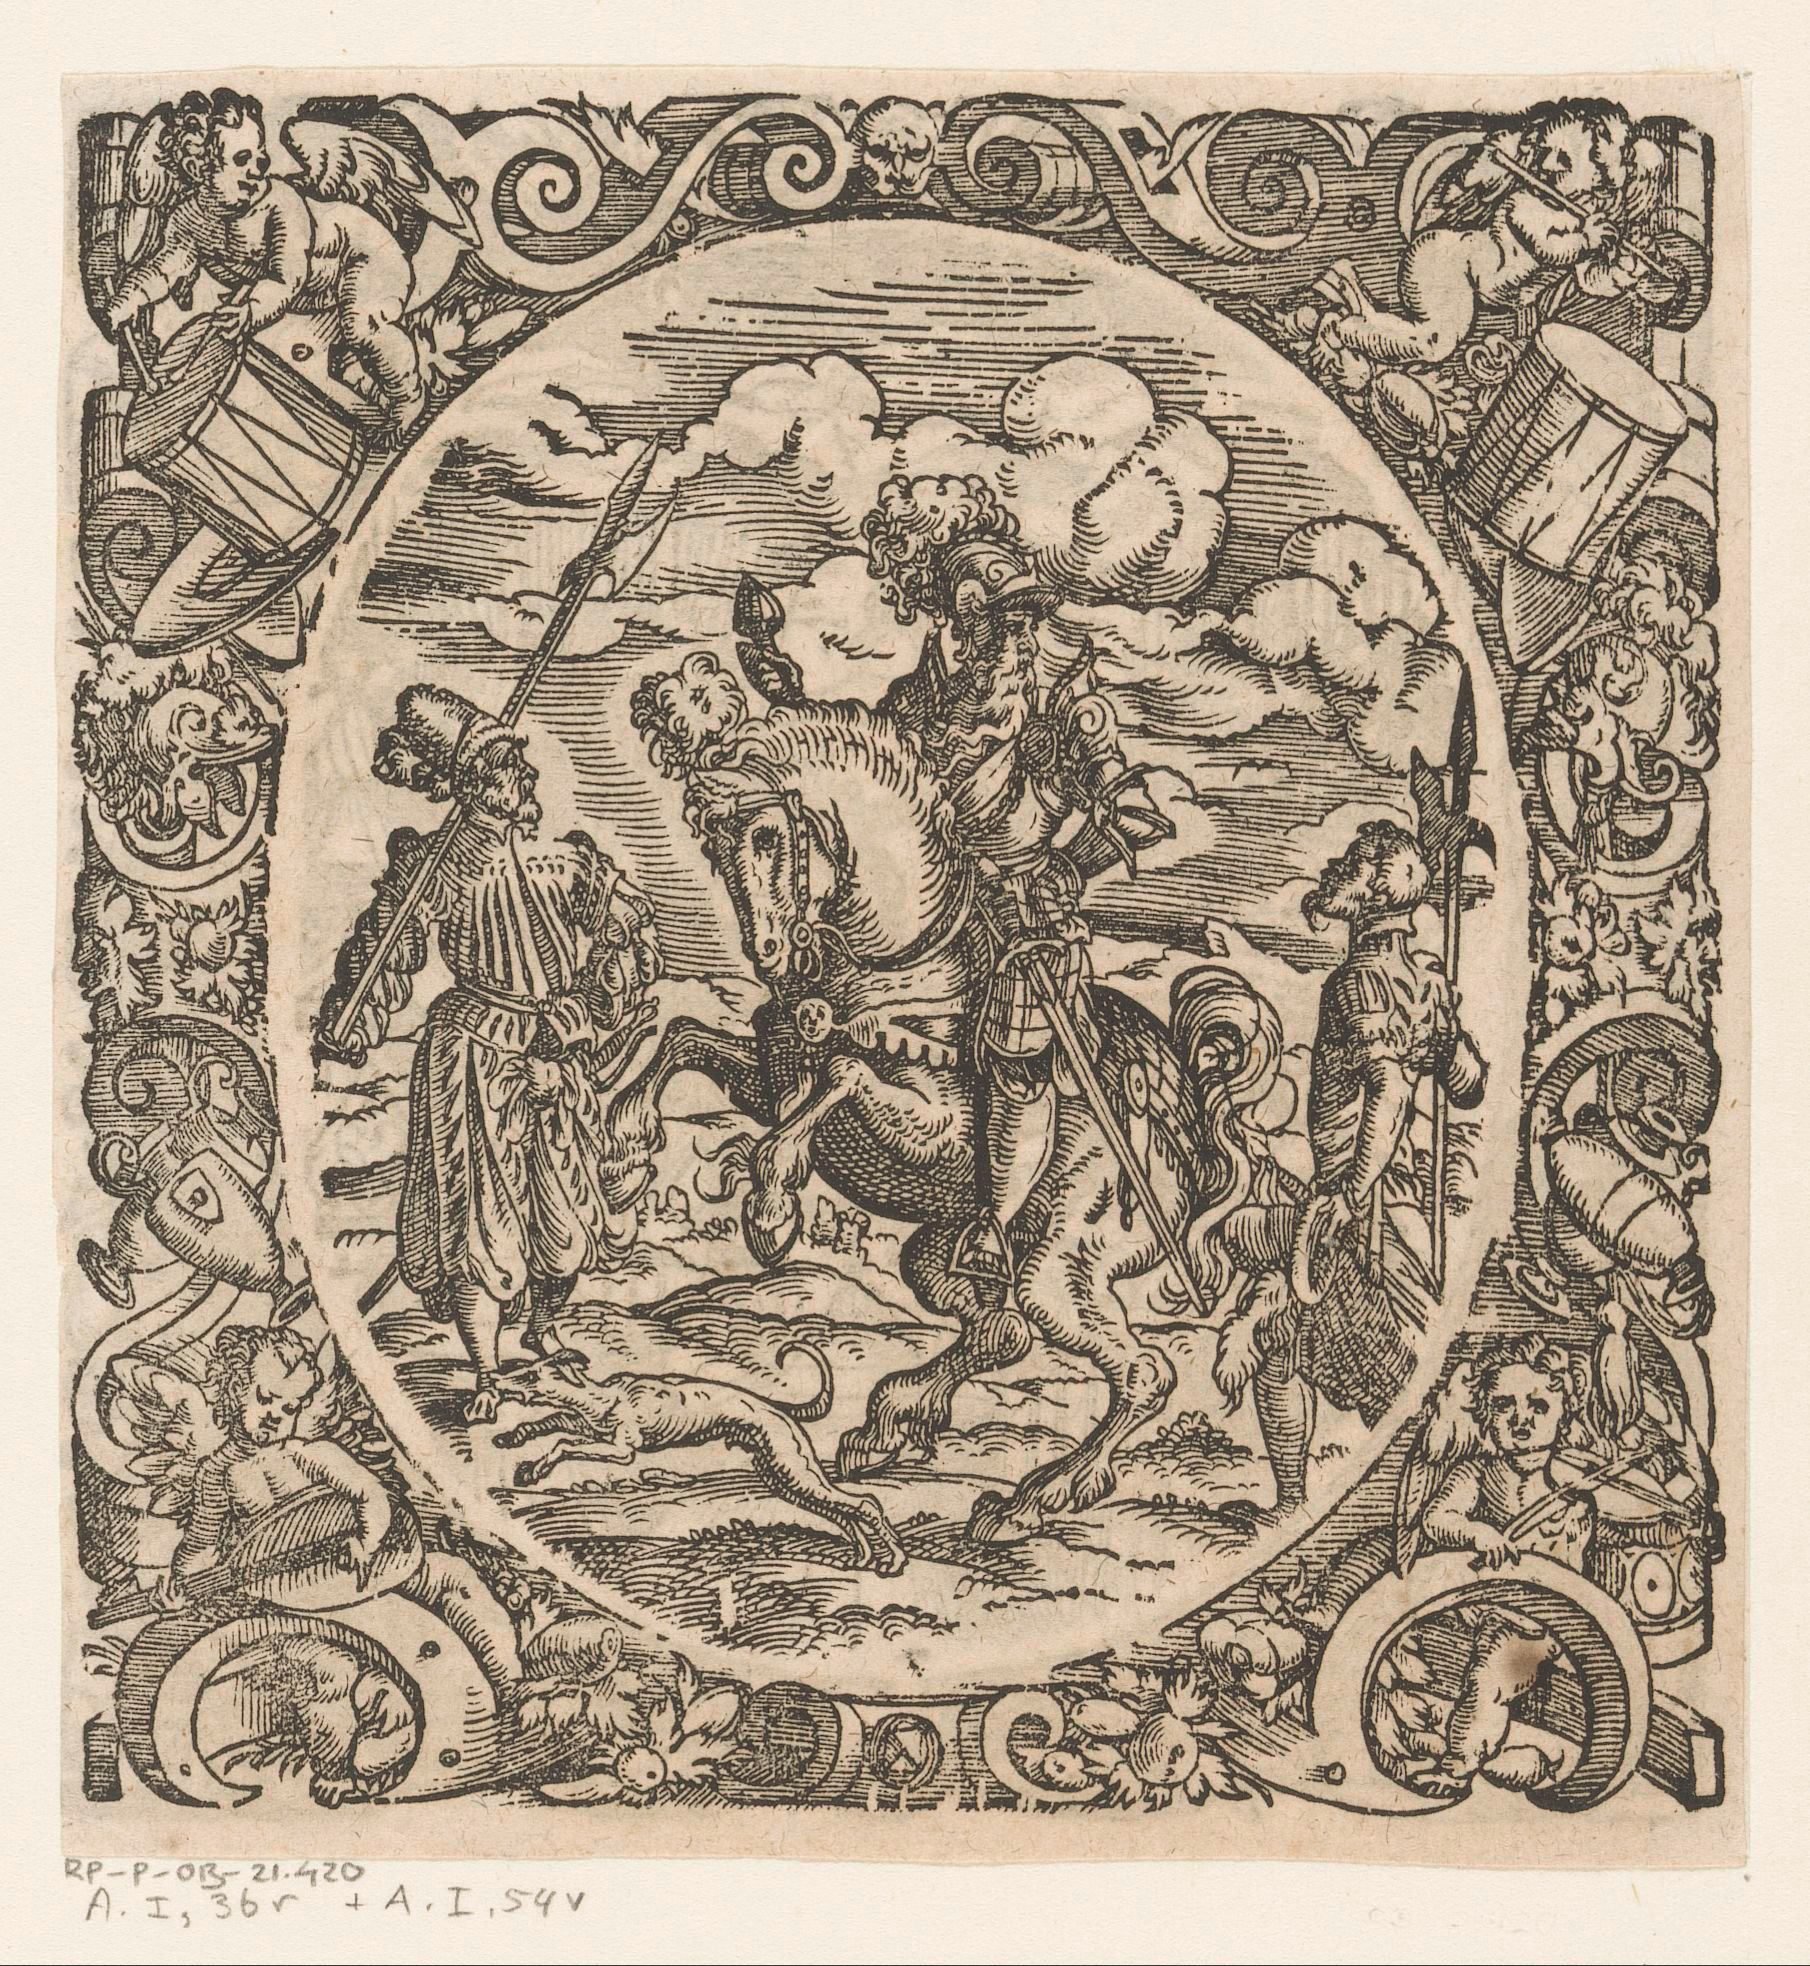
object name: print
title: Officier te paard met twee soldaten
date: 1573-1578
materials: paper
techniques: woodcut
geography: frankfurt am main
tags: riding a horse, ass, or mule; rider, horseman, warfare; military affairs, the soldier; the soldier's life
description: Zowel de voorstelling als de ornamentrand werd gebruikt voor verschillende edities van Leonhardt Fronspergers Kriegsbuch.